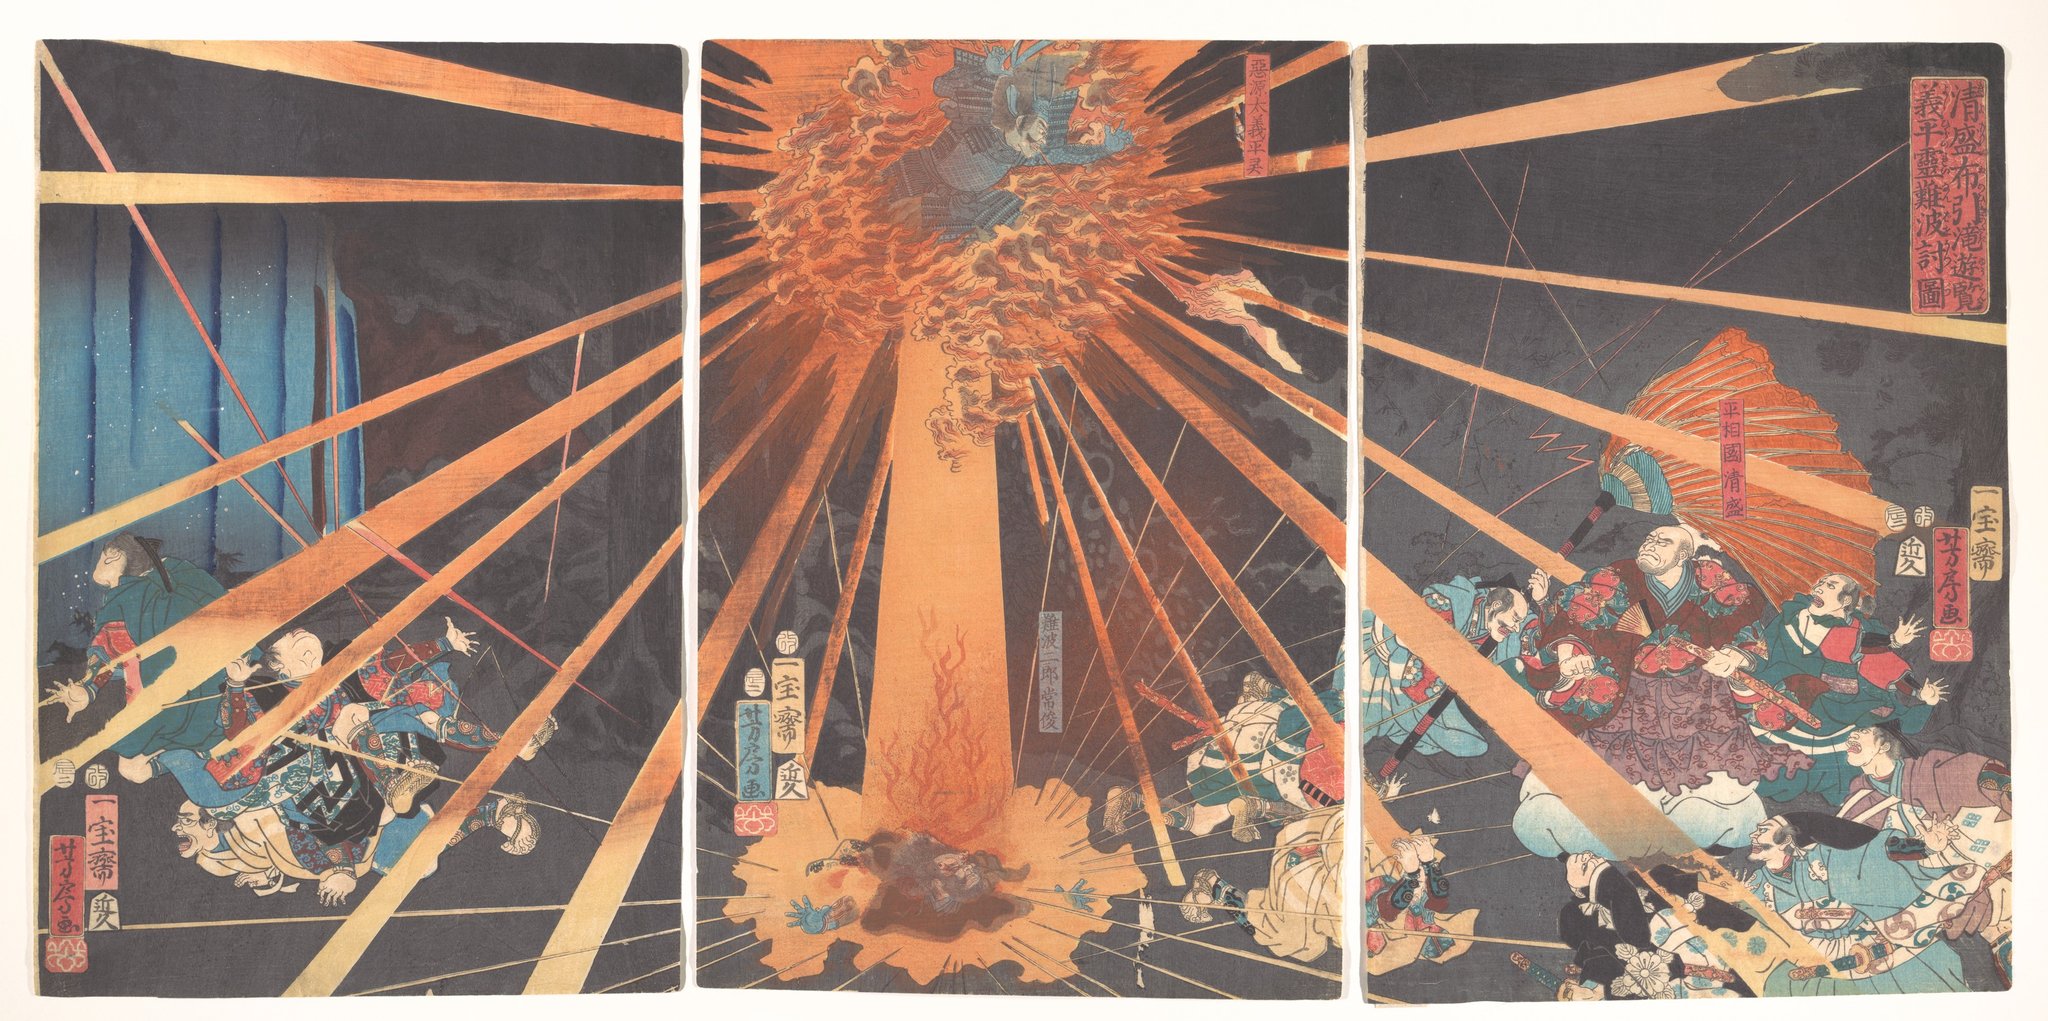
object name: print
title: Kiyomori’s Visit to Nunobiki Waterfall: The Ghost of Yoshihira Taking Revenge on Nanba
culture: japanese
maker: utagawa yoshifusa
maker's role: artist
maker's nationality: japanese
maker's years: 1837-1860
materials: ink, paper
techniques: nishiki e, woodblock print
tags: men